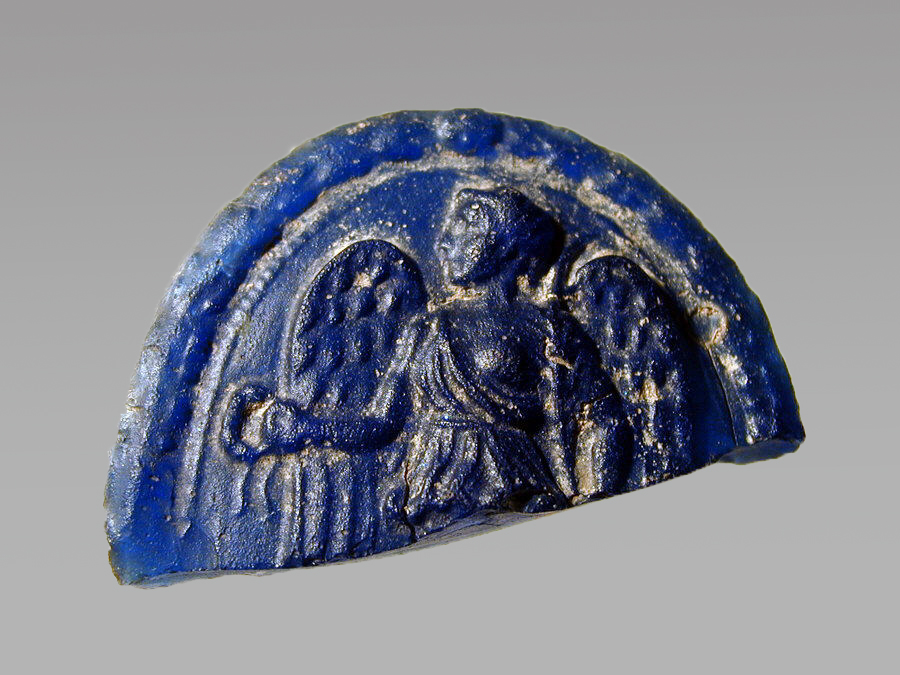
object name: medallion, victory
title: Glass medallion of winged Victory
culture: roman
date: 1-100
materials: glass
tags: victory